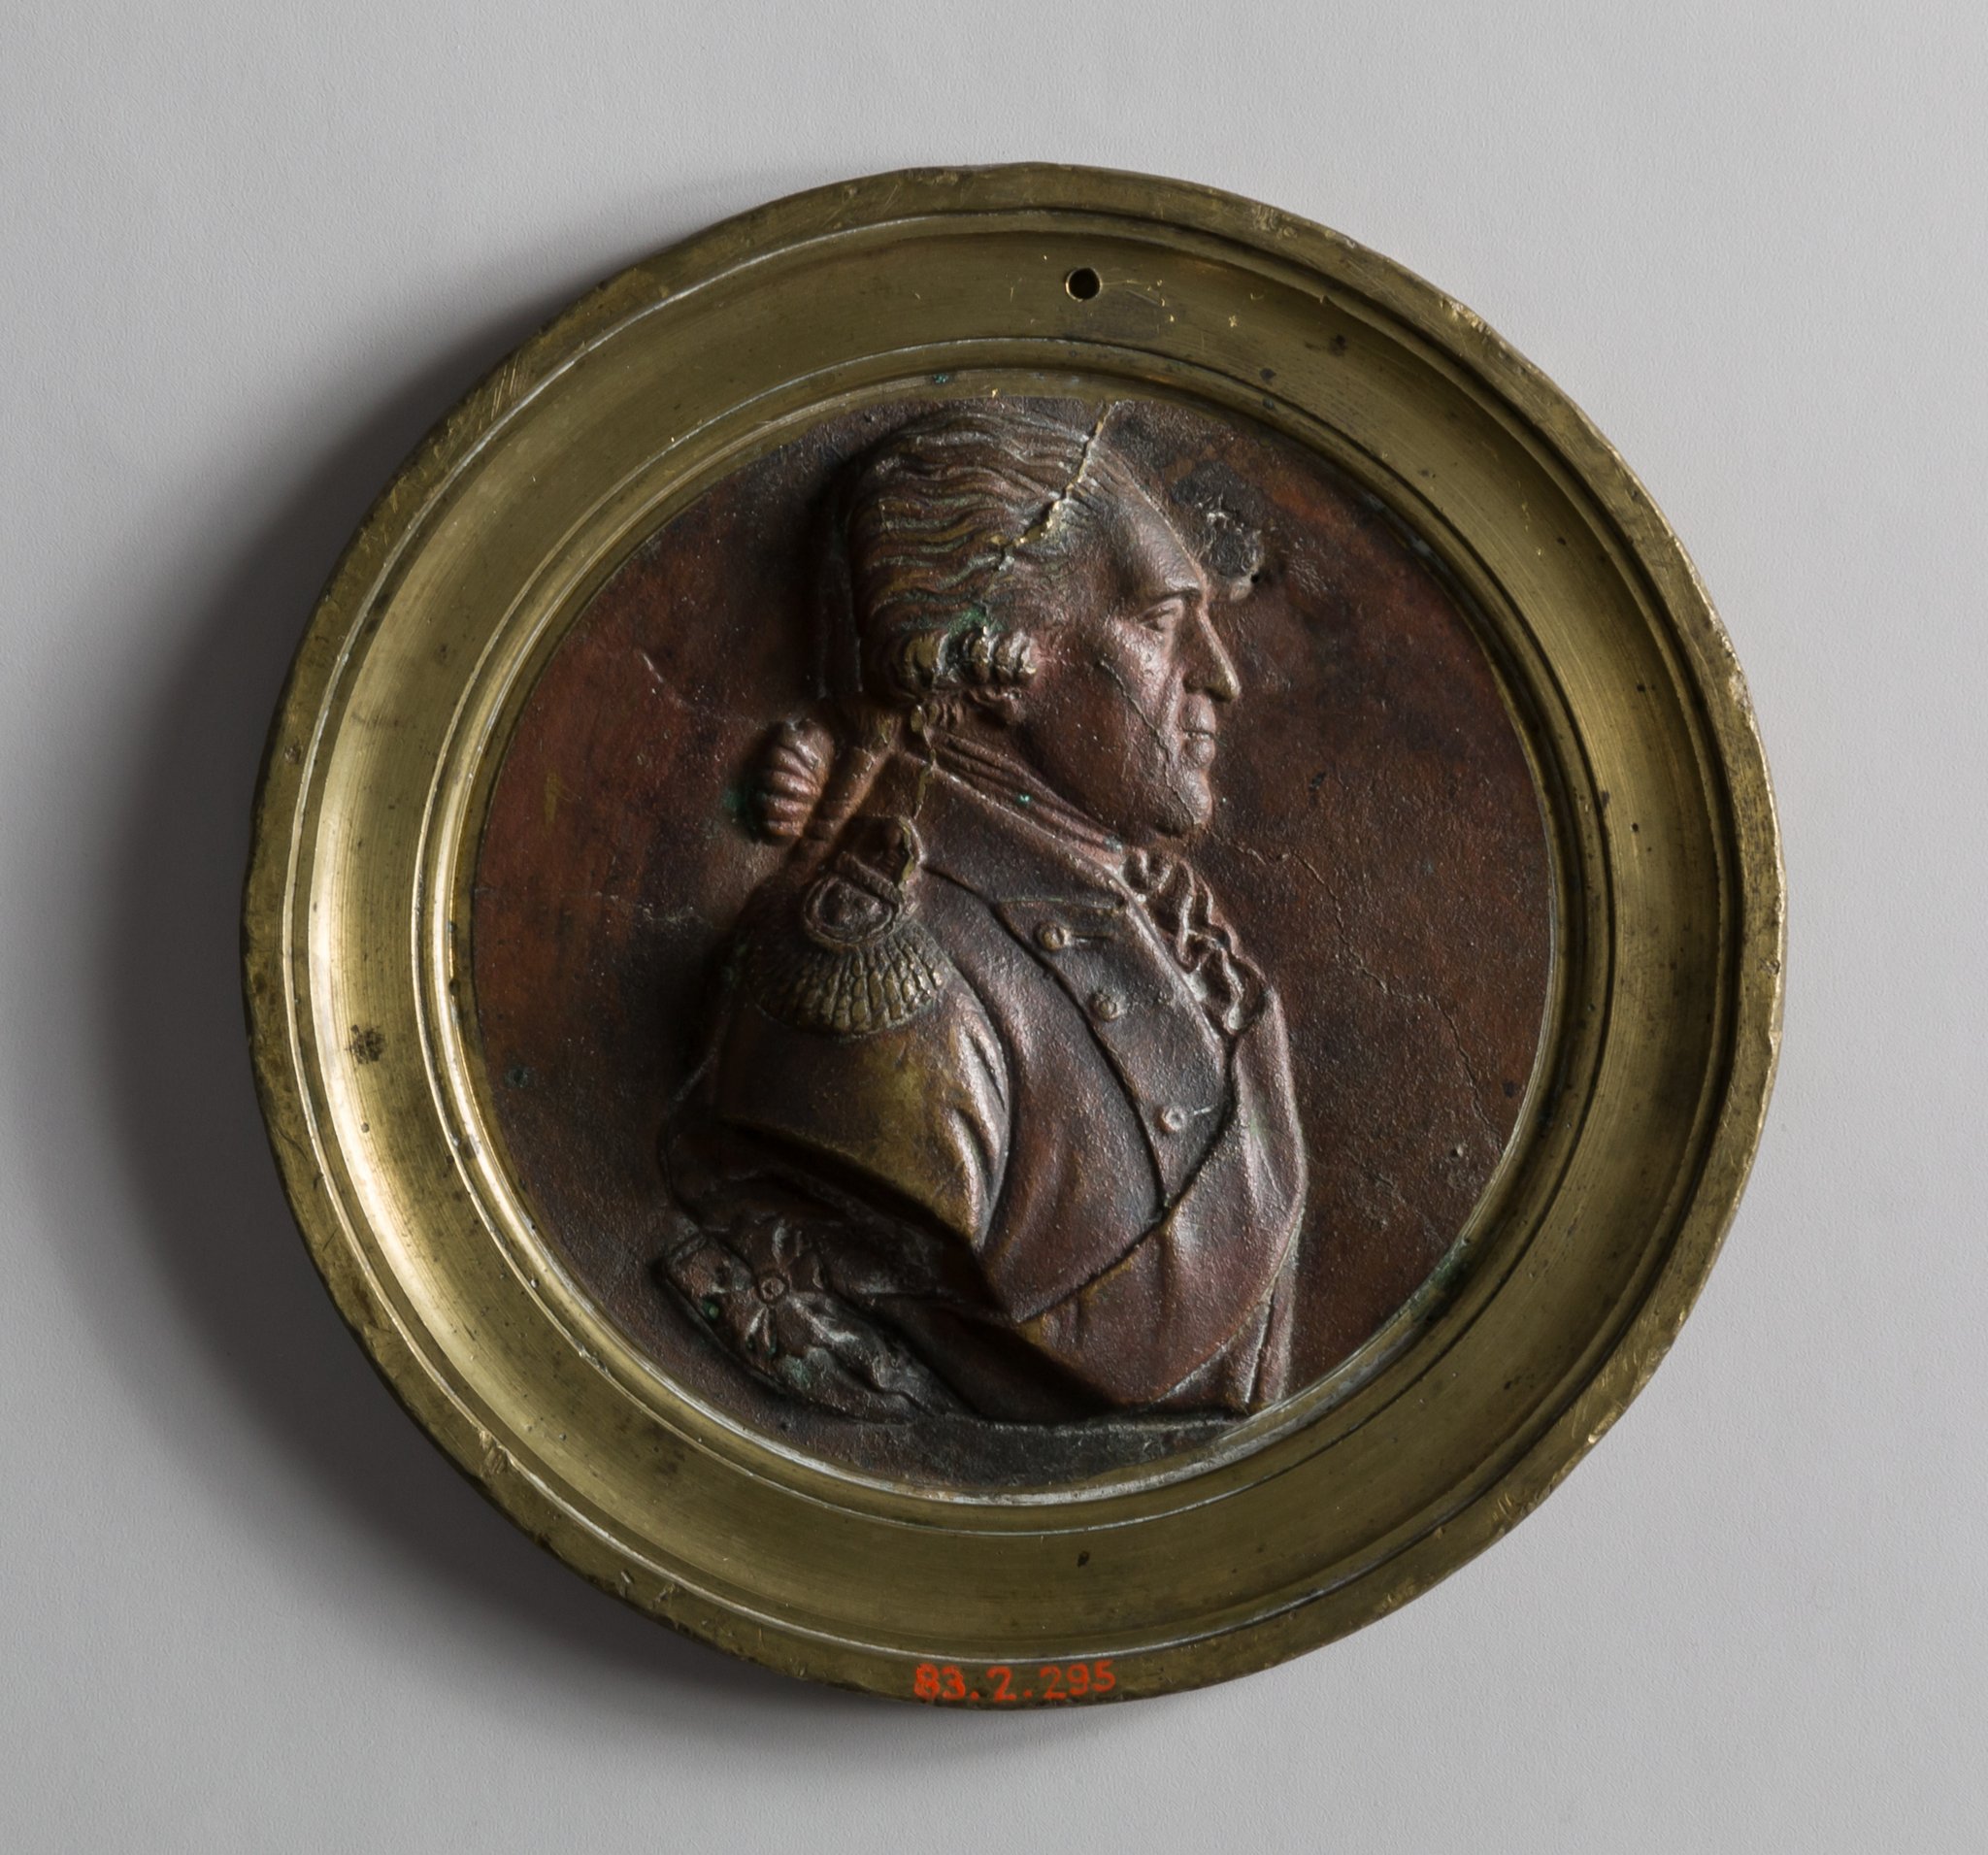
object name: medallion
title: Medallion of the Marquis de Lafayette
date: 1775-1800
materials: brass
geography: france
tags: men,profiles,marquis de lafayette